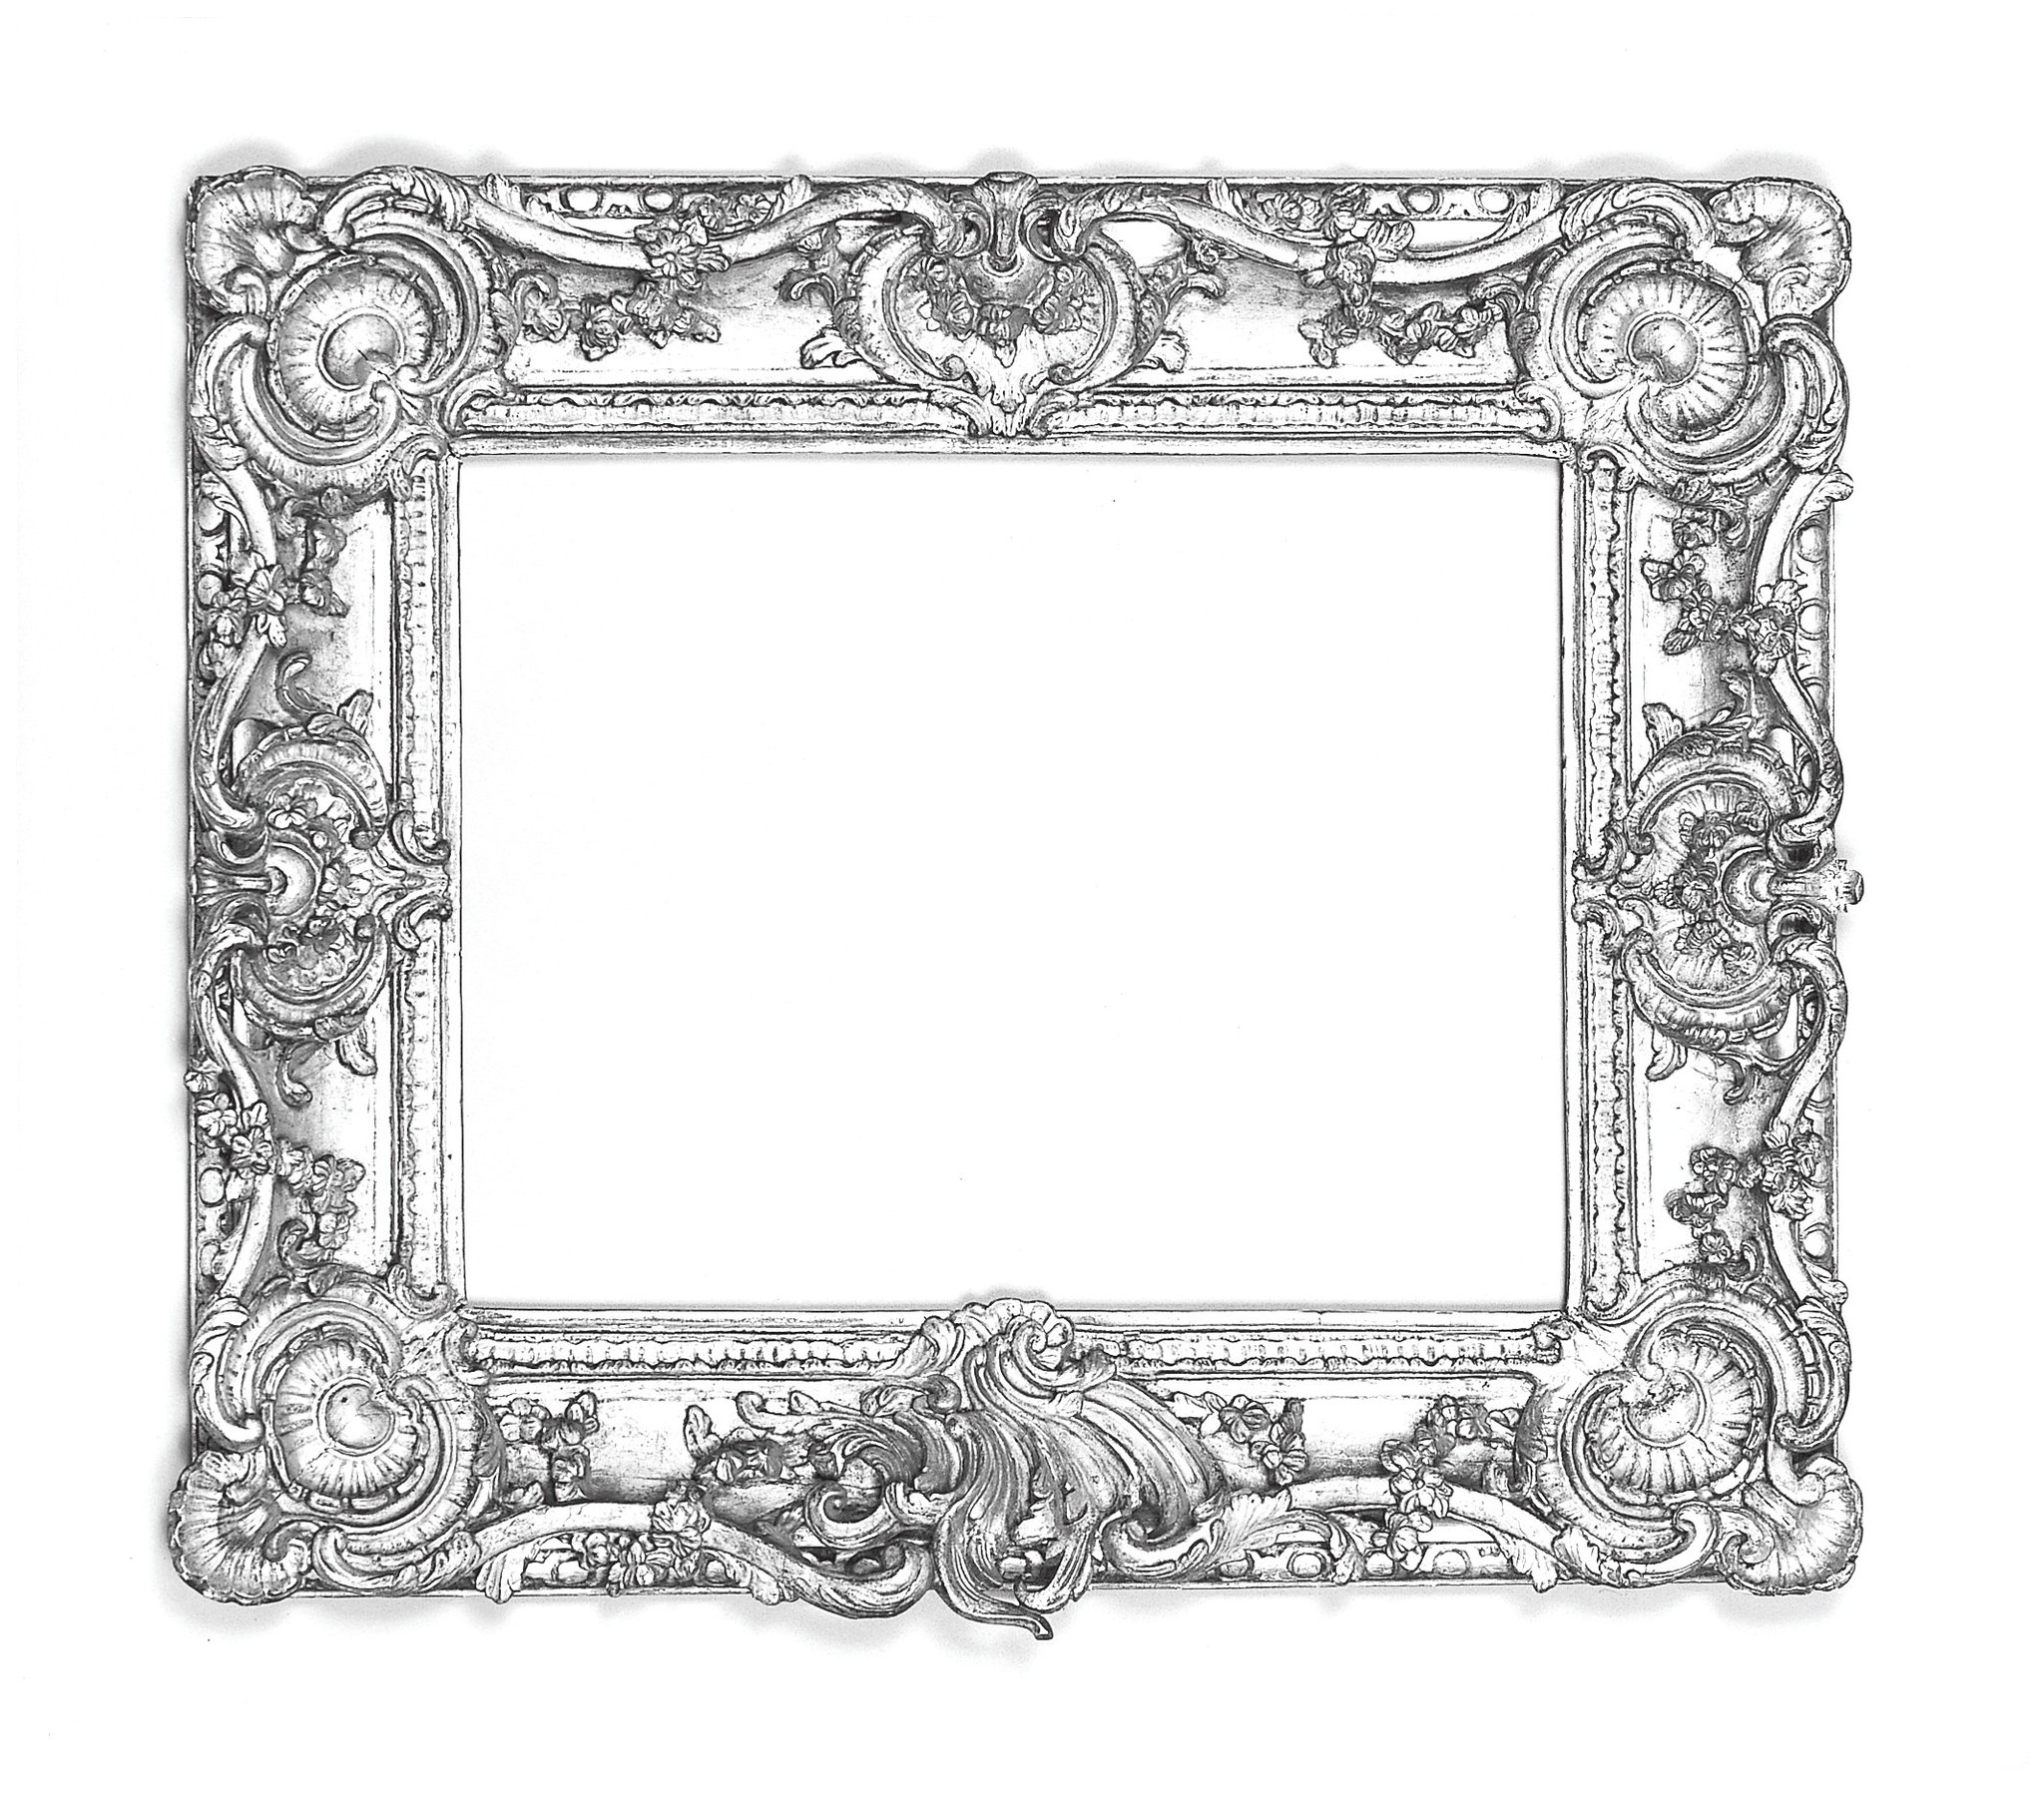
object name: frame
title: Swept frame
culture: french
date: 1755-1760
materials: feather, wood